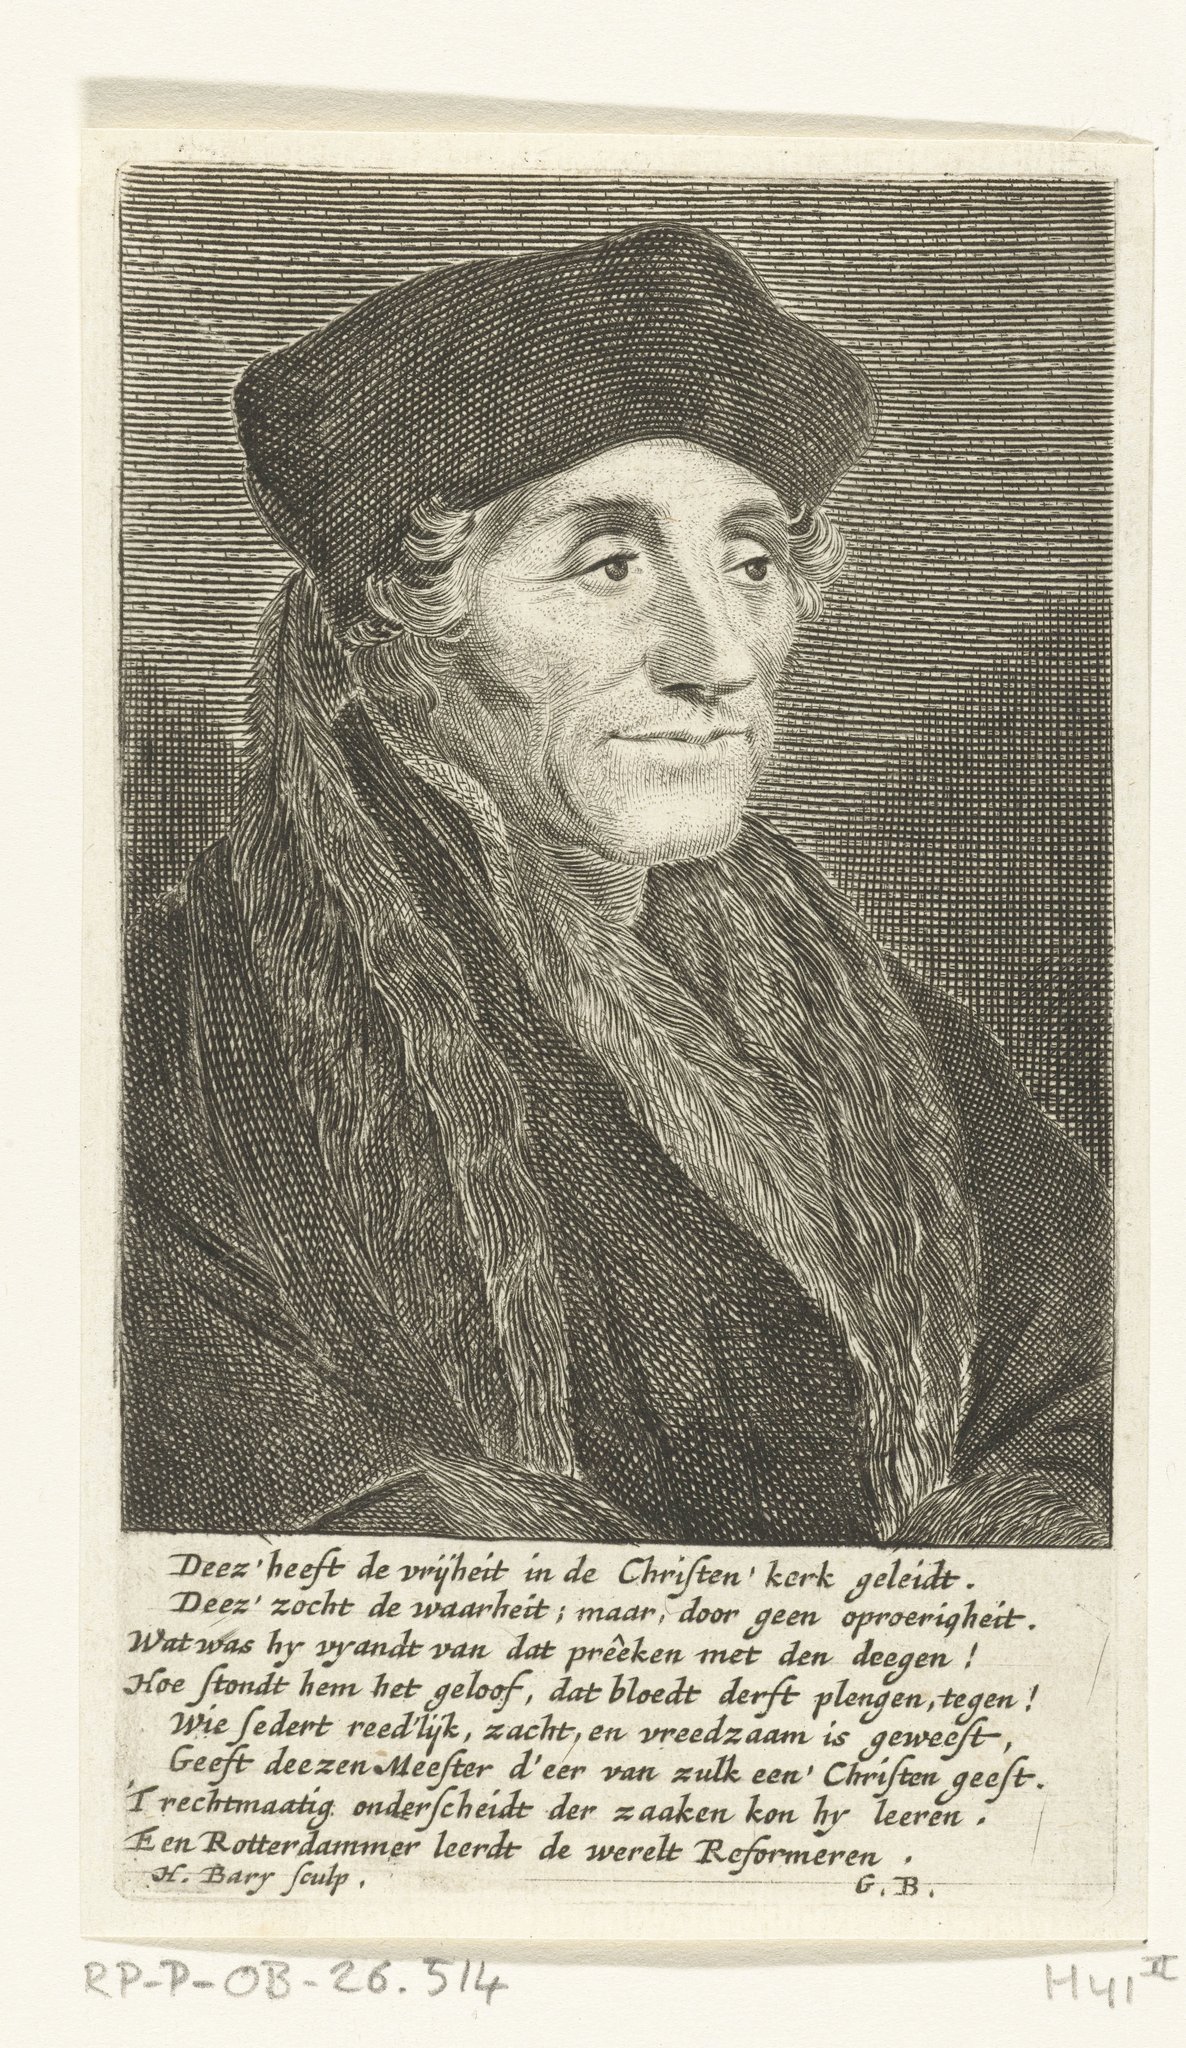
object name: print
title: Portret van Desiderius Erasmus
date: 1657-1707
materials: paper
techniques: engraving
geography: netherlands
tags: rotterdam, desiderius erasmus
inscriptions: collector's mark: Lugt 2228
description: Borstbeeld van Desiderius Erasmus. Onder de voorstelling een vers van acht regels in het Nederlands.